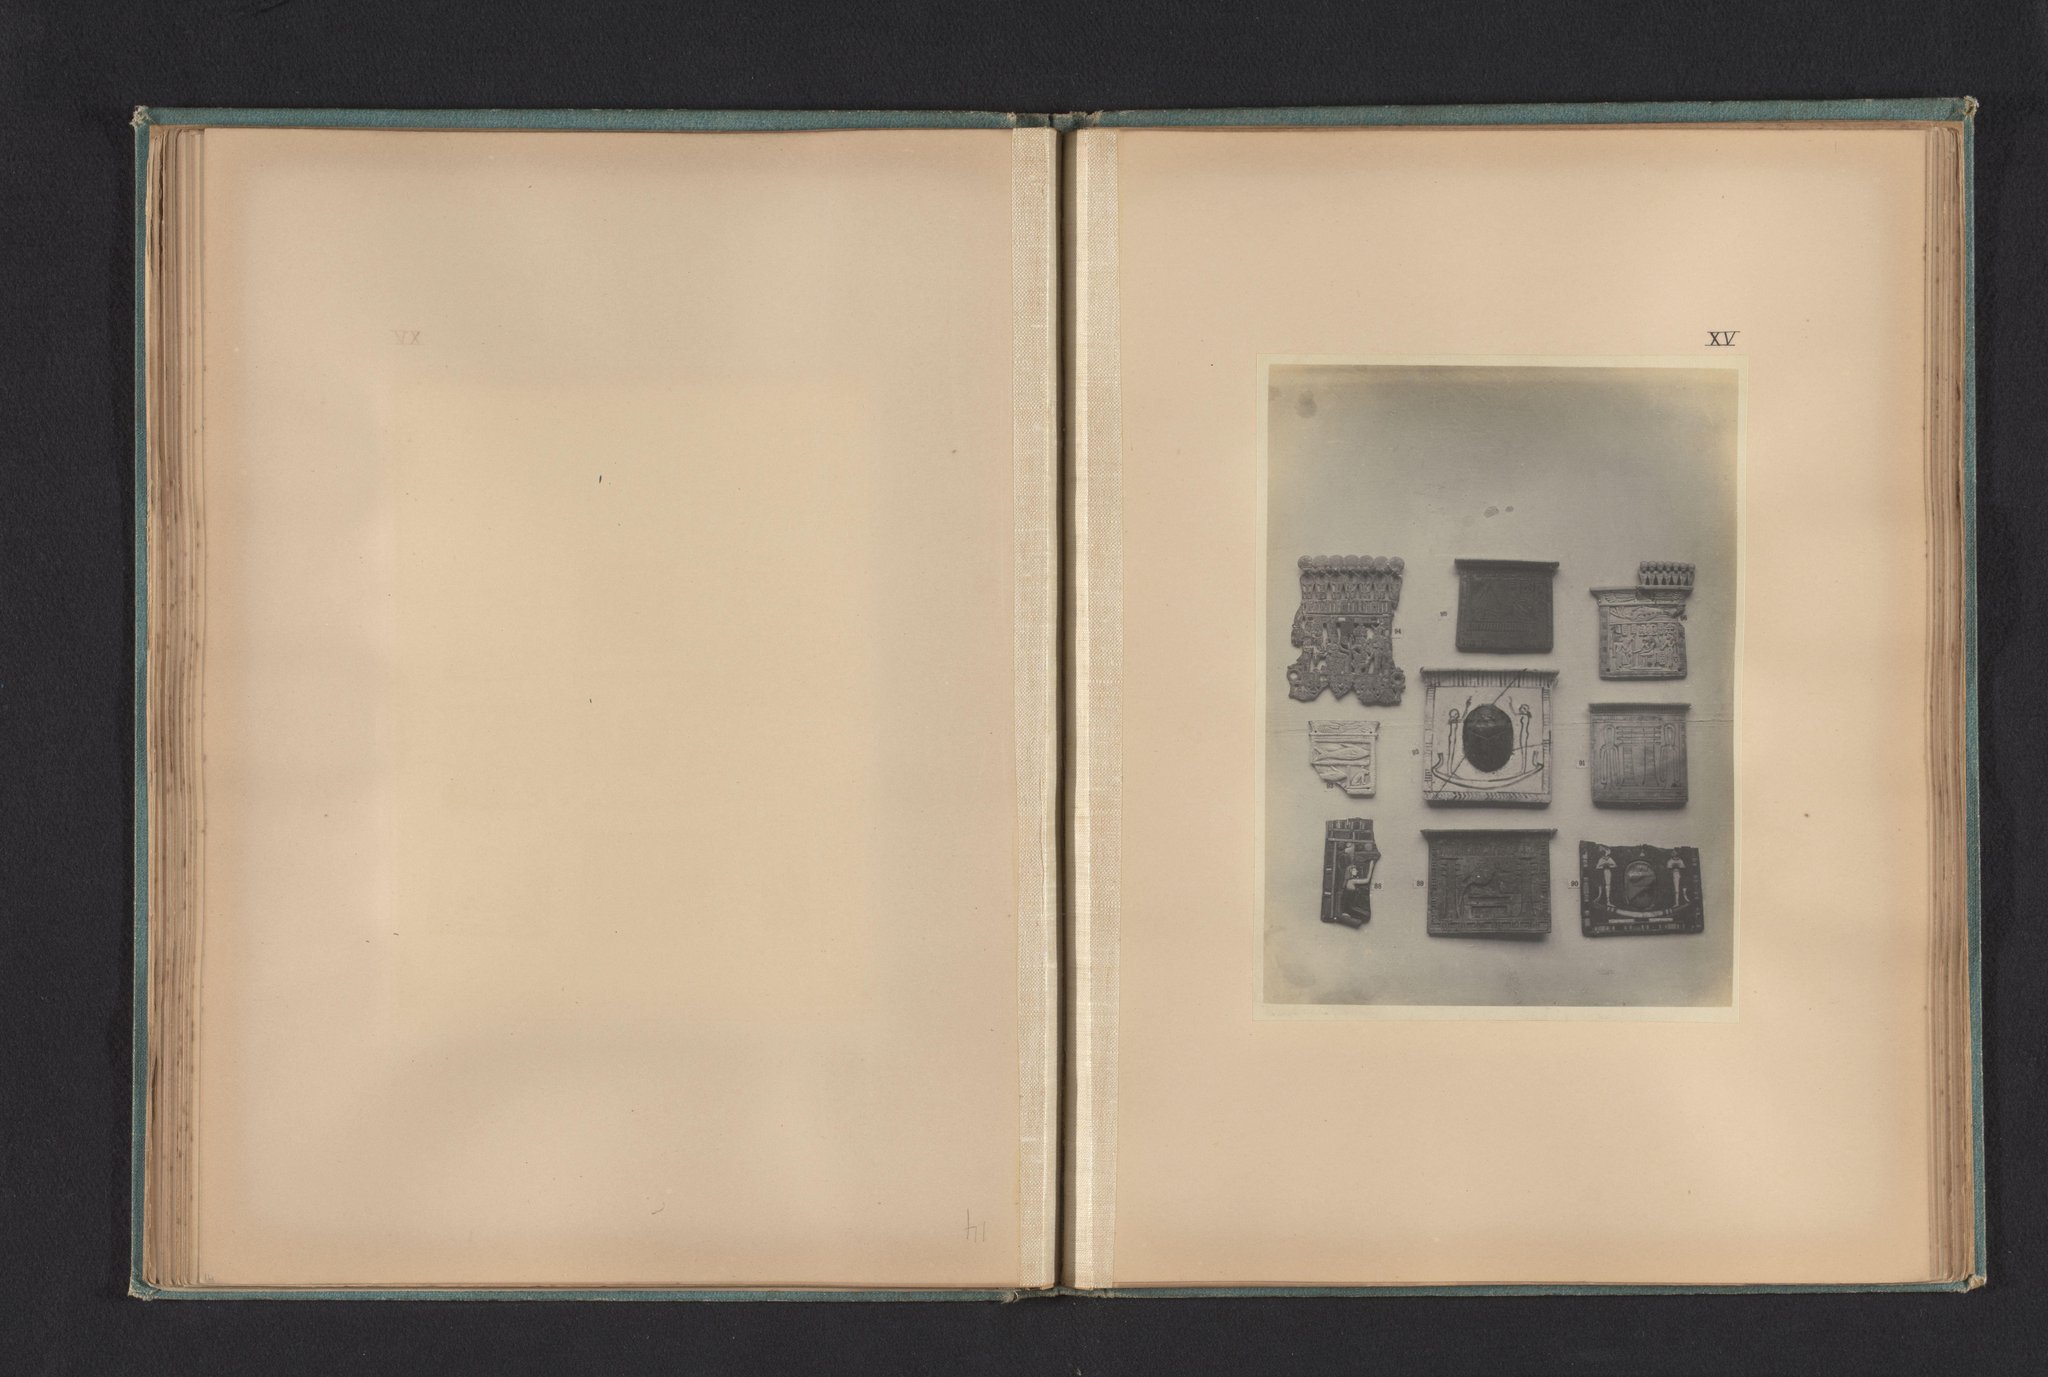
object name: page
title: Negen Egyptische pectoralen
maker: Anonymous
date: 1890-1895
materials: photographic support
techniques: gelatin silver print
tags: ornaments, jewels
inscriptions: number: ‘XV’